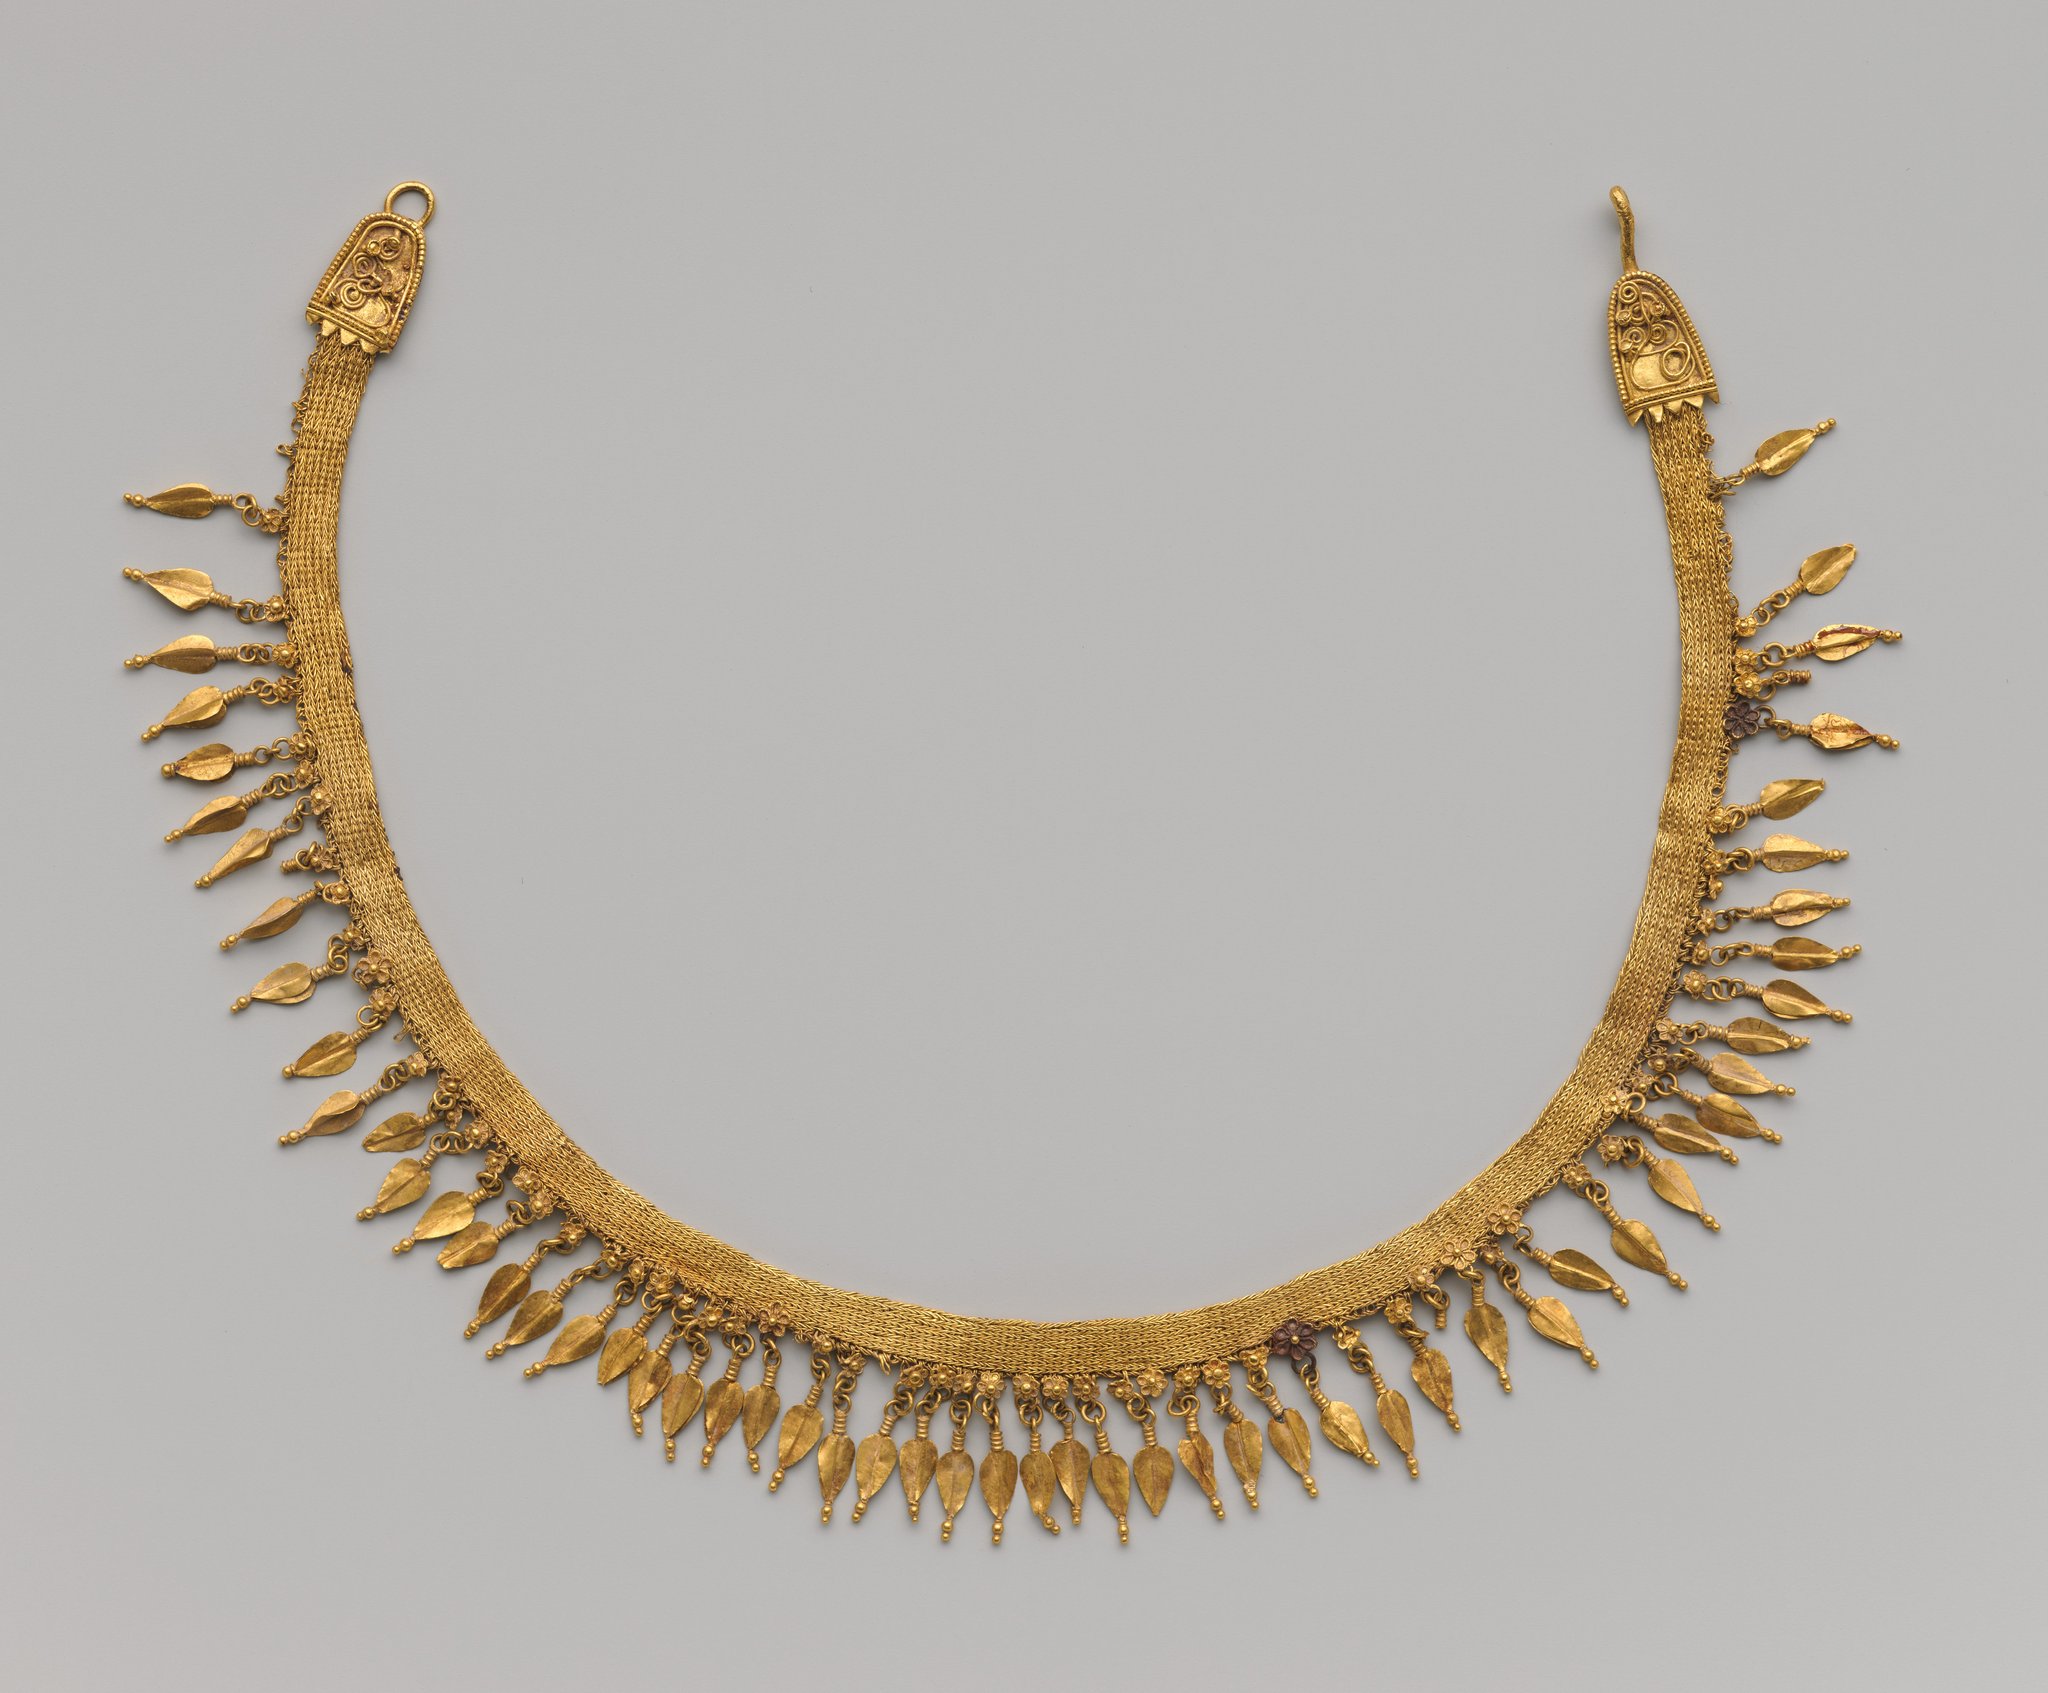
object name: necklace with pendant and rosette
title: Gold strap necklace with beechnut pendants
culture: greek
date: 400-301 BCE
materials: gold